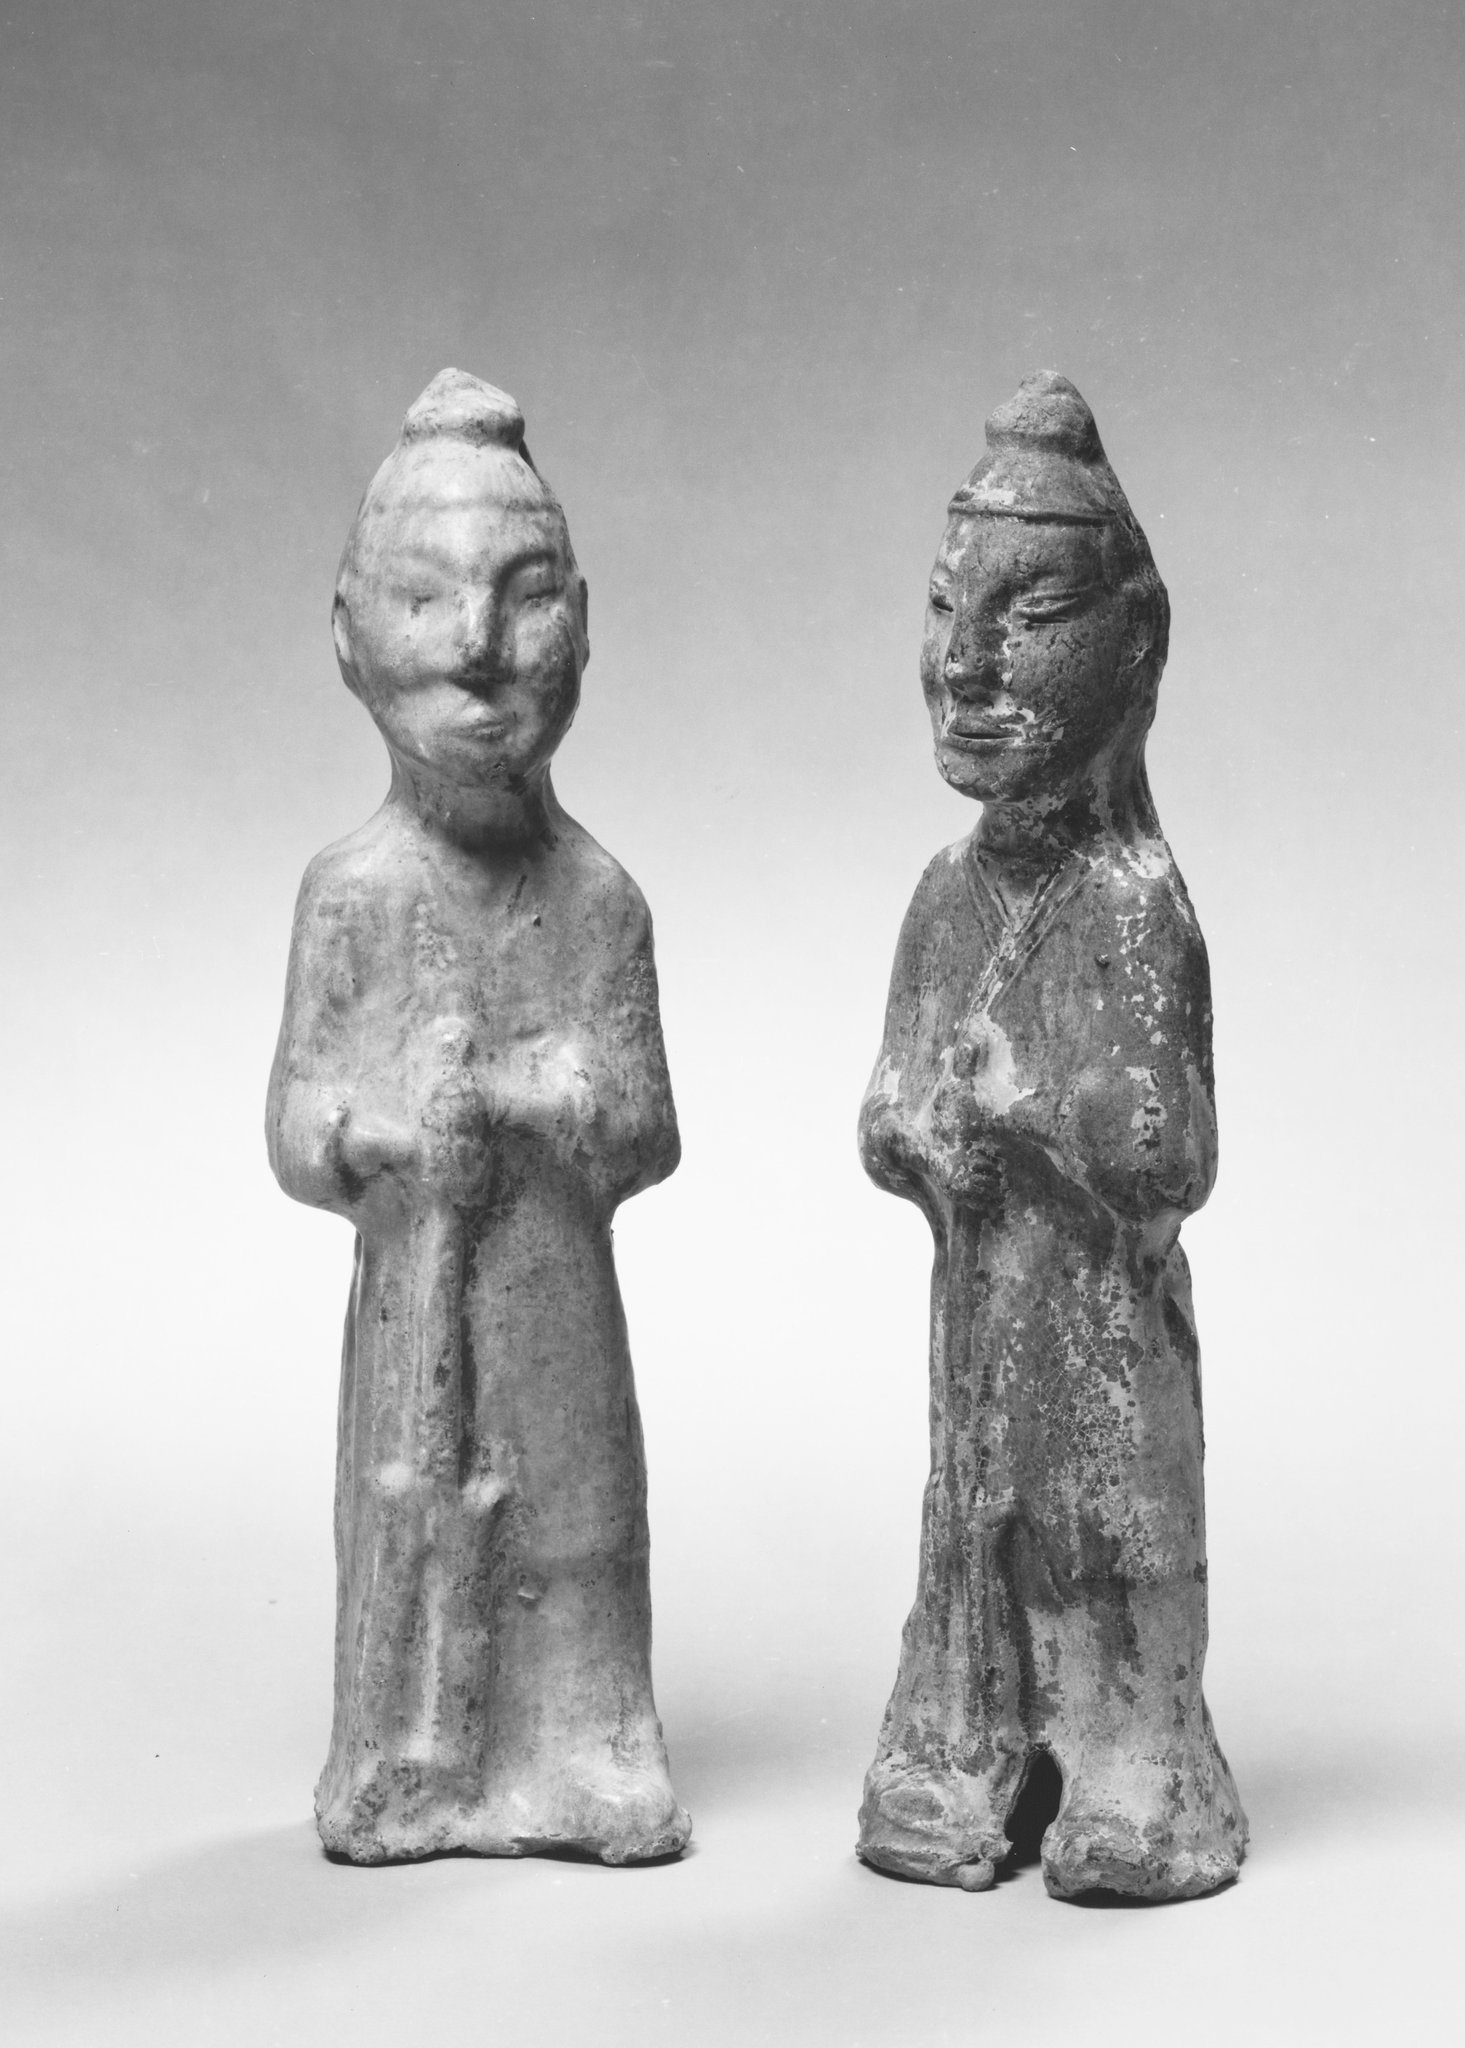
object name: figure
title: Standing Farmer holding a Pitchfork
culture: chinese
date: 3200 BCE-1700 CE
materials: earthenware, glaze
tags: farmers